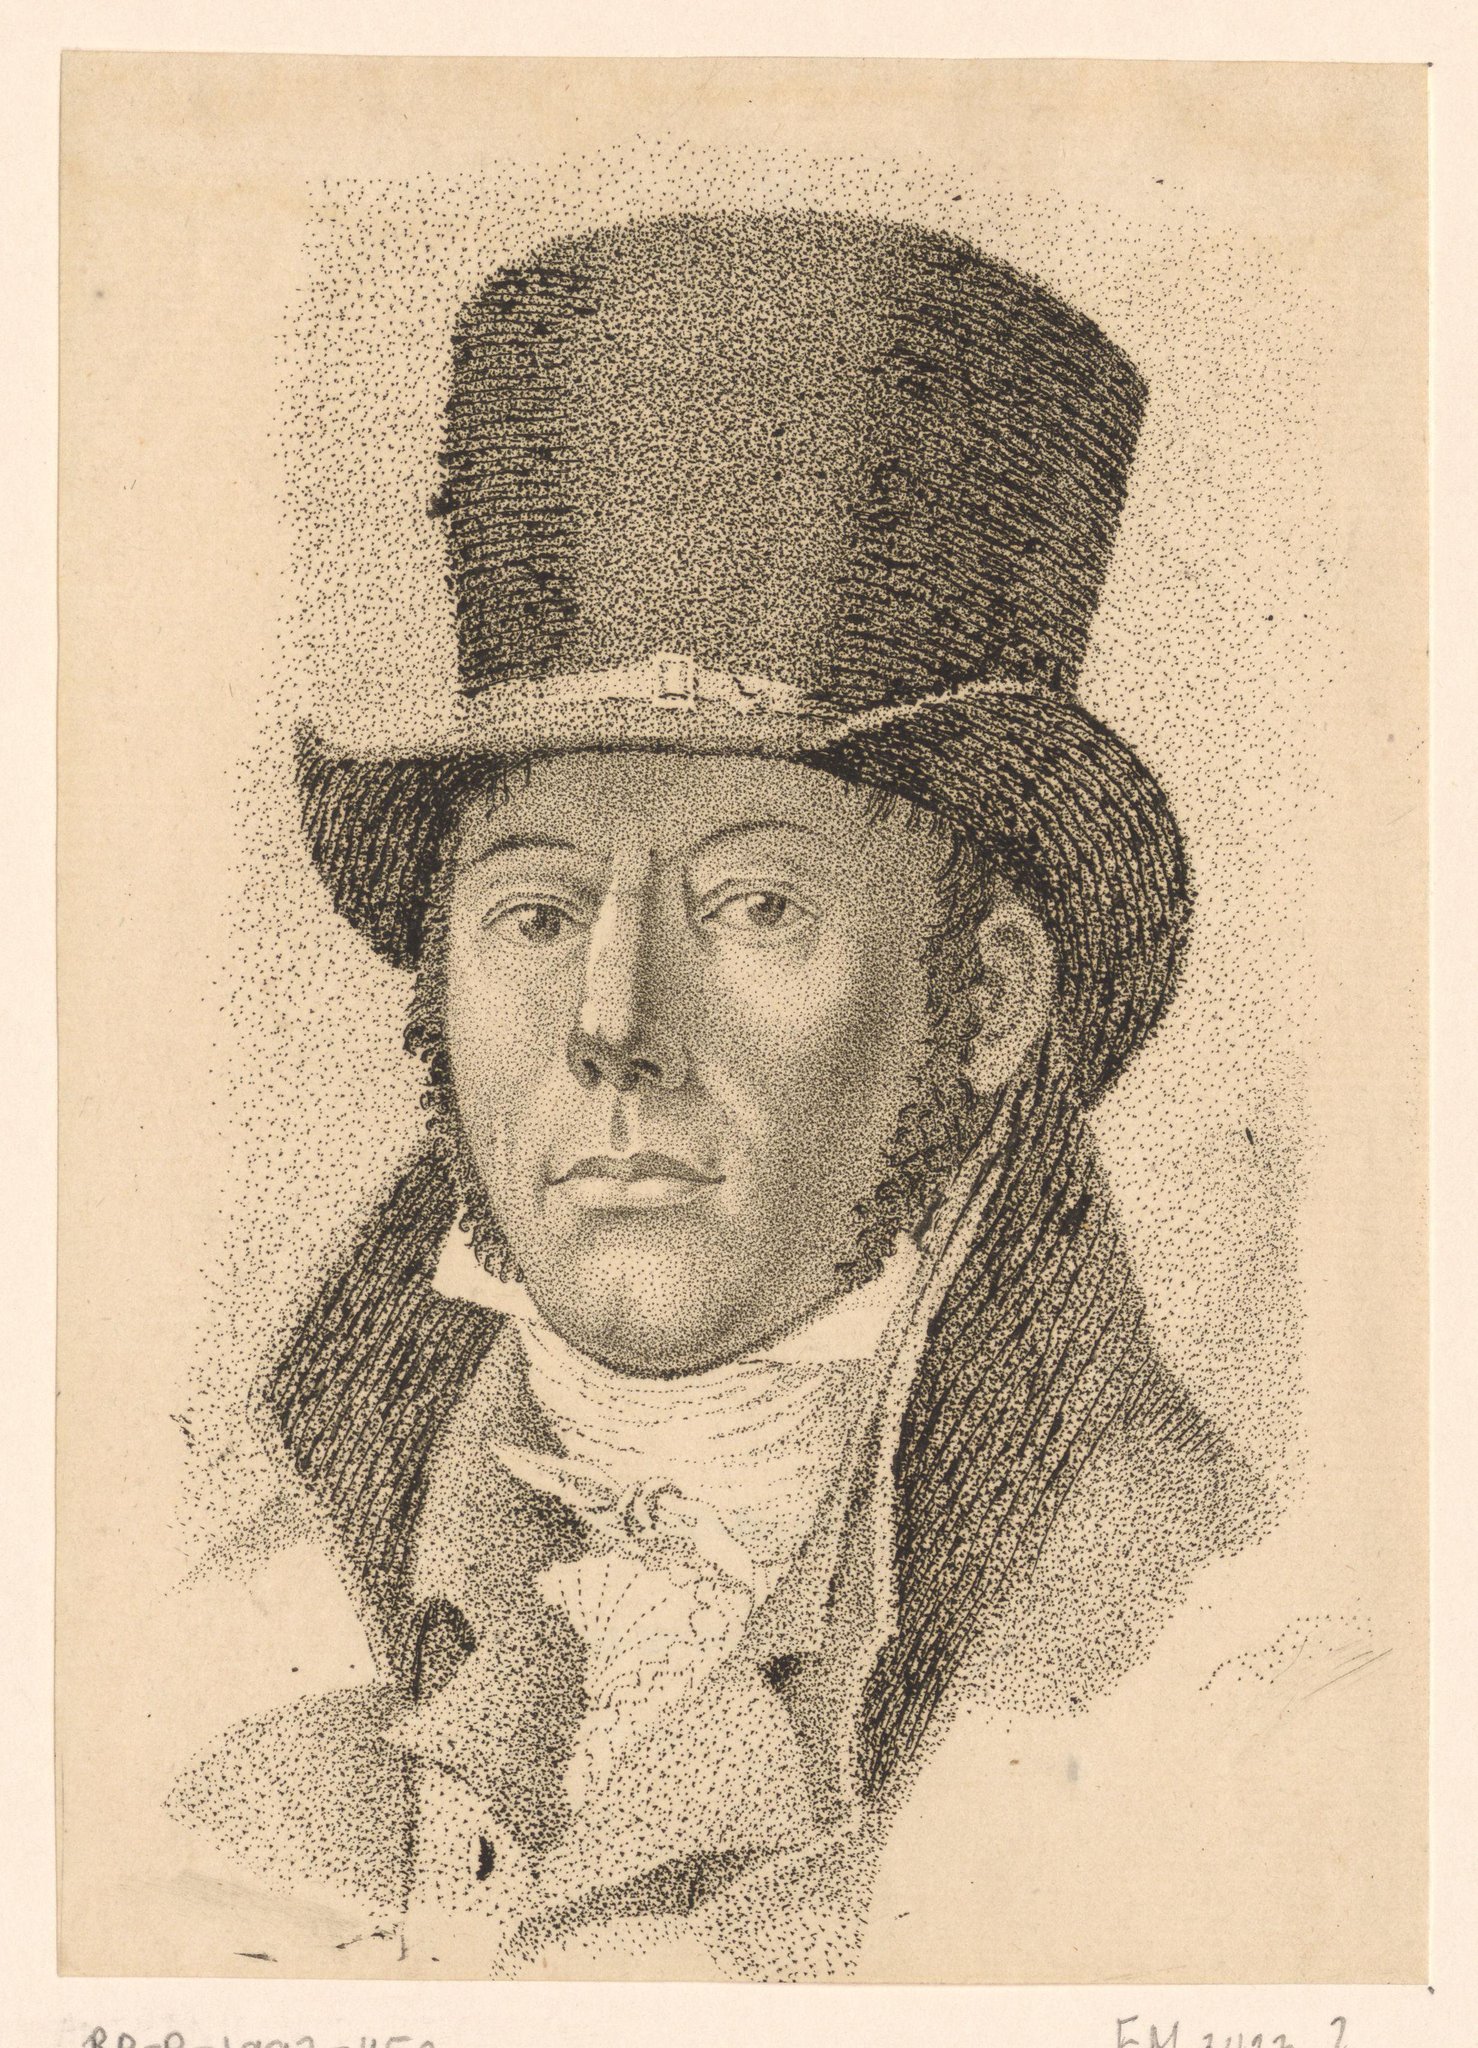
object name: print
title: Portret van Jacob Ernst Marcus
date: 1805-1834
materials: paper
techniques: engraving, etching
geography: netherlands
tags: jacob ernst marcus, historical persons, portrait, self-portrait of graphic artist, head-gear: top hat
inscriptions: collector's mark: Lugt 2228